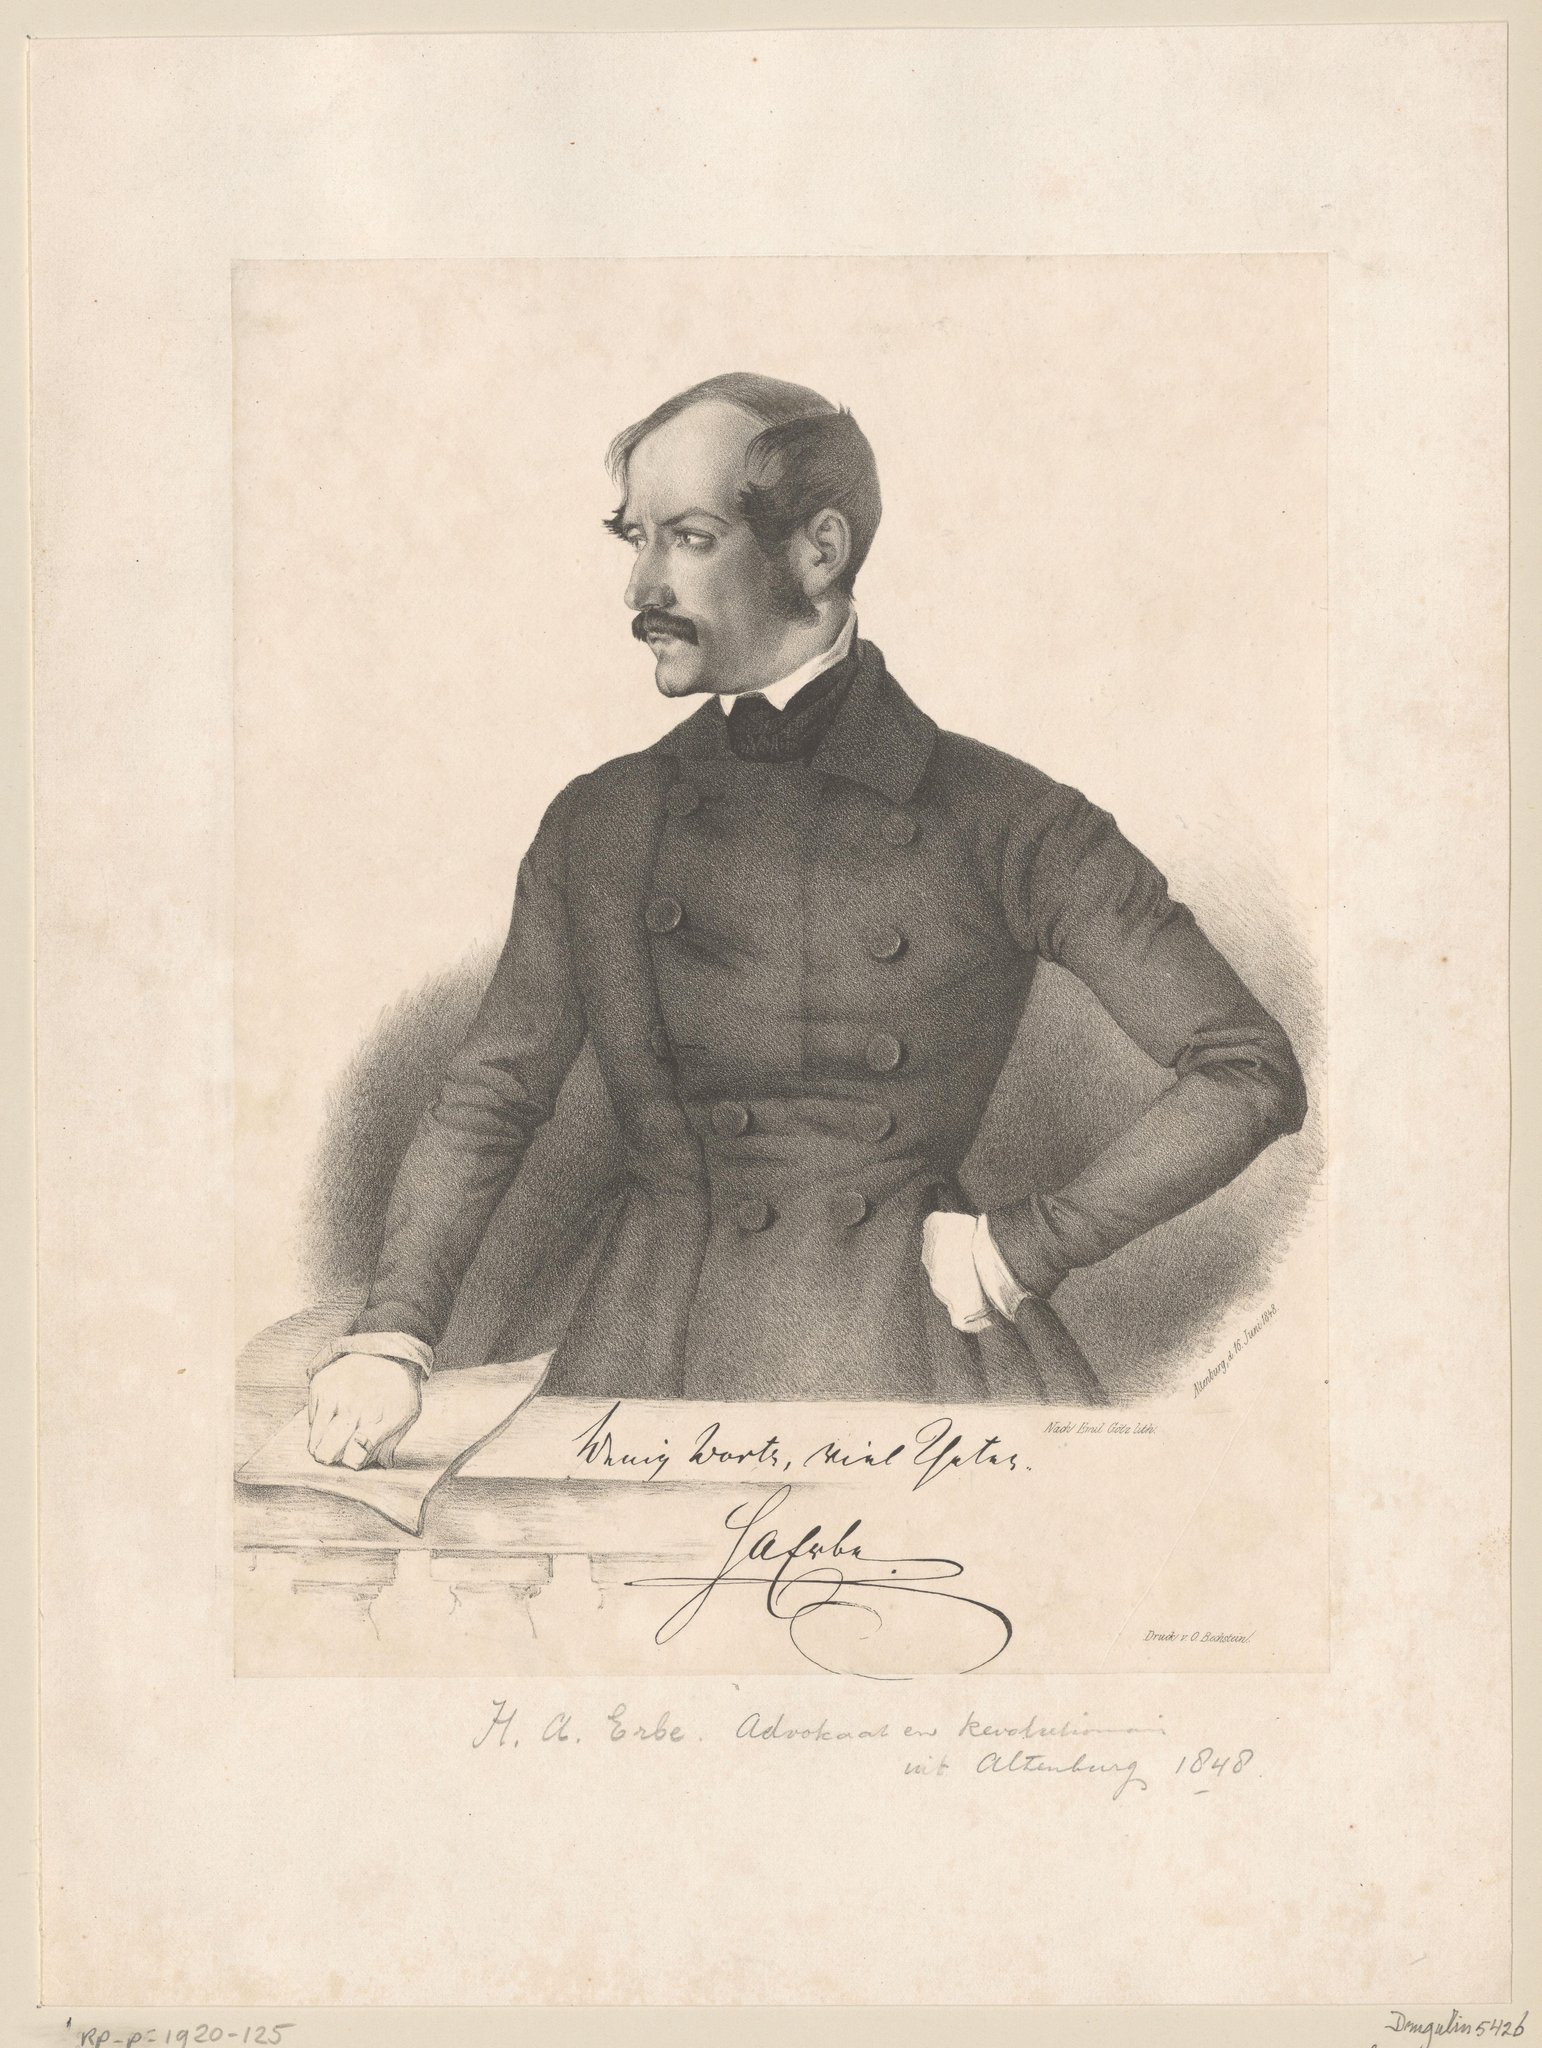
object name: print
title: Portret van Hans Alfred Erbe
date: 1848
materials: paper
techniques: lithograph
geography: altenburg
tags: new york (city), historical persons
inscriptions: date